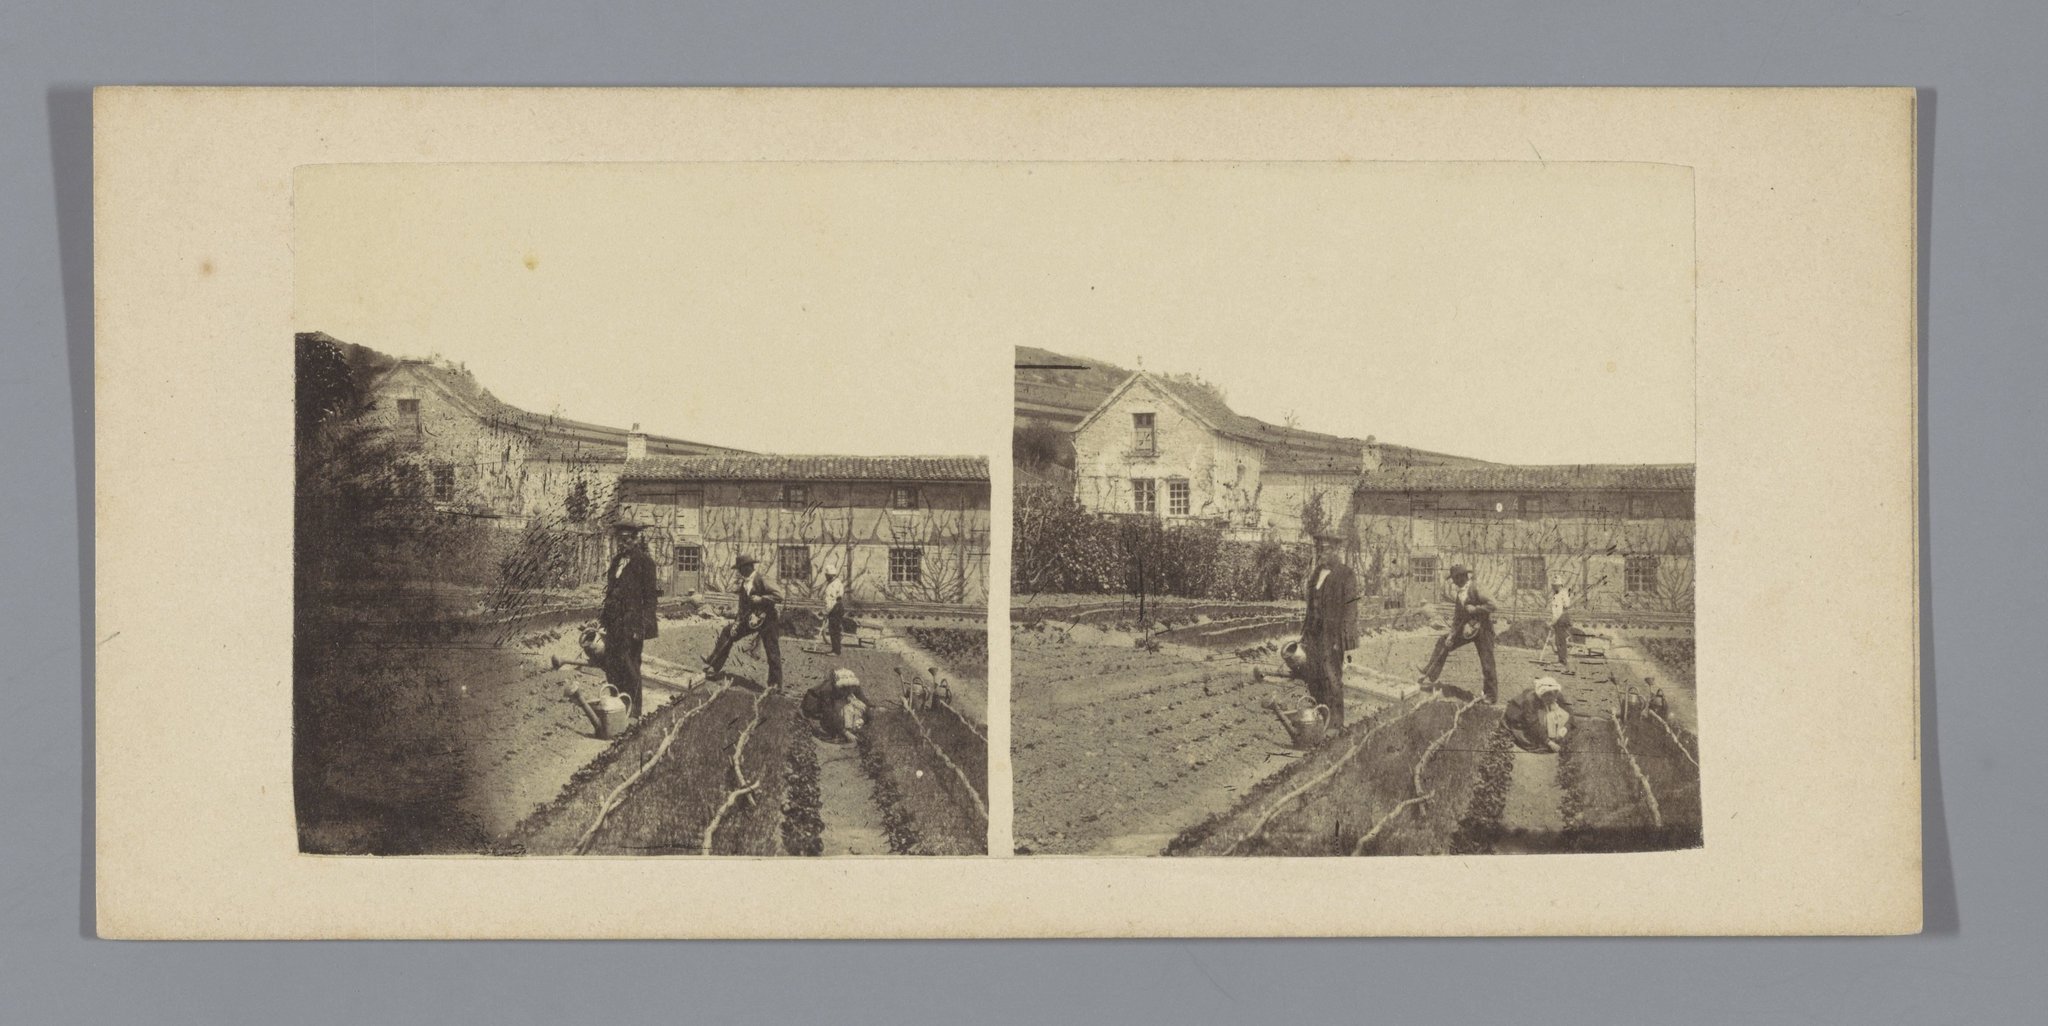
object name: stereograph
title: Landarbeiders in een moestuin voor een huis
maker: Anonymous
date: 1850-1880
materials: cardboard, photographic support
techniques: albumen print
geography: europe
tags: farmers, working class, labourers, europe